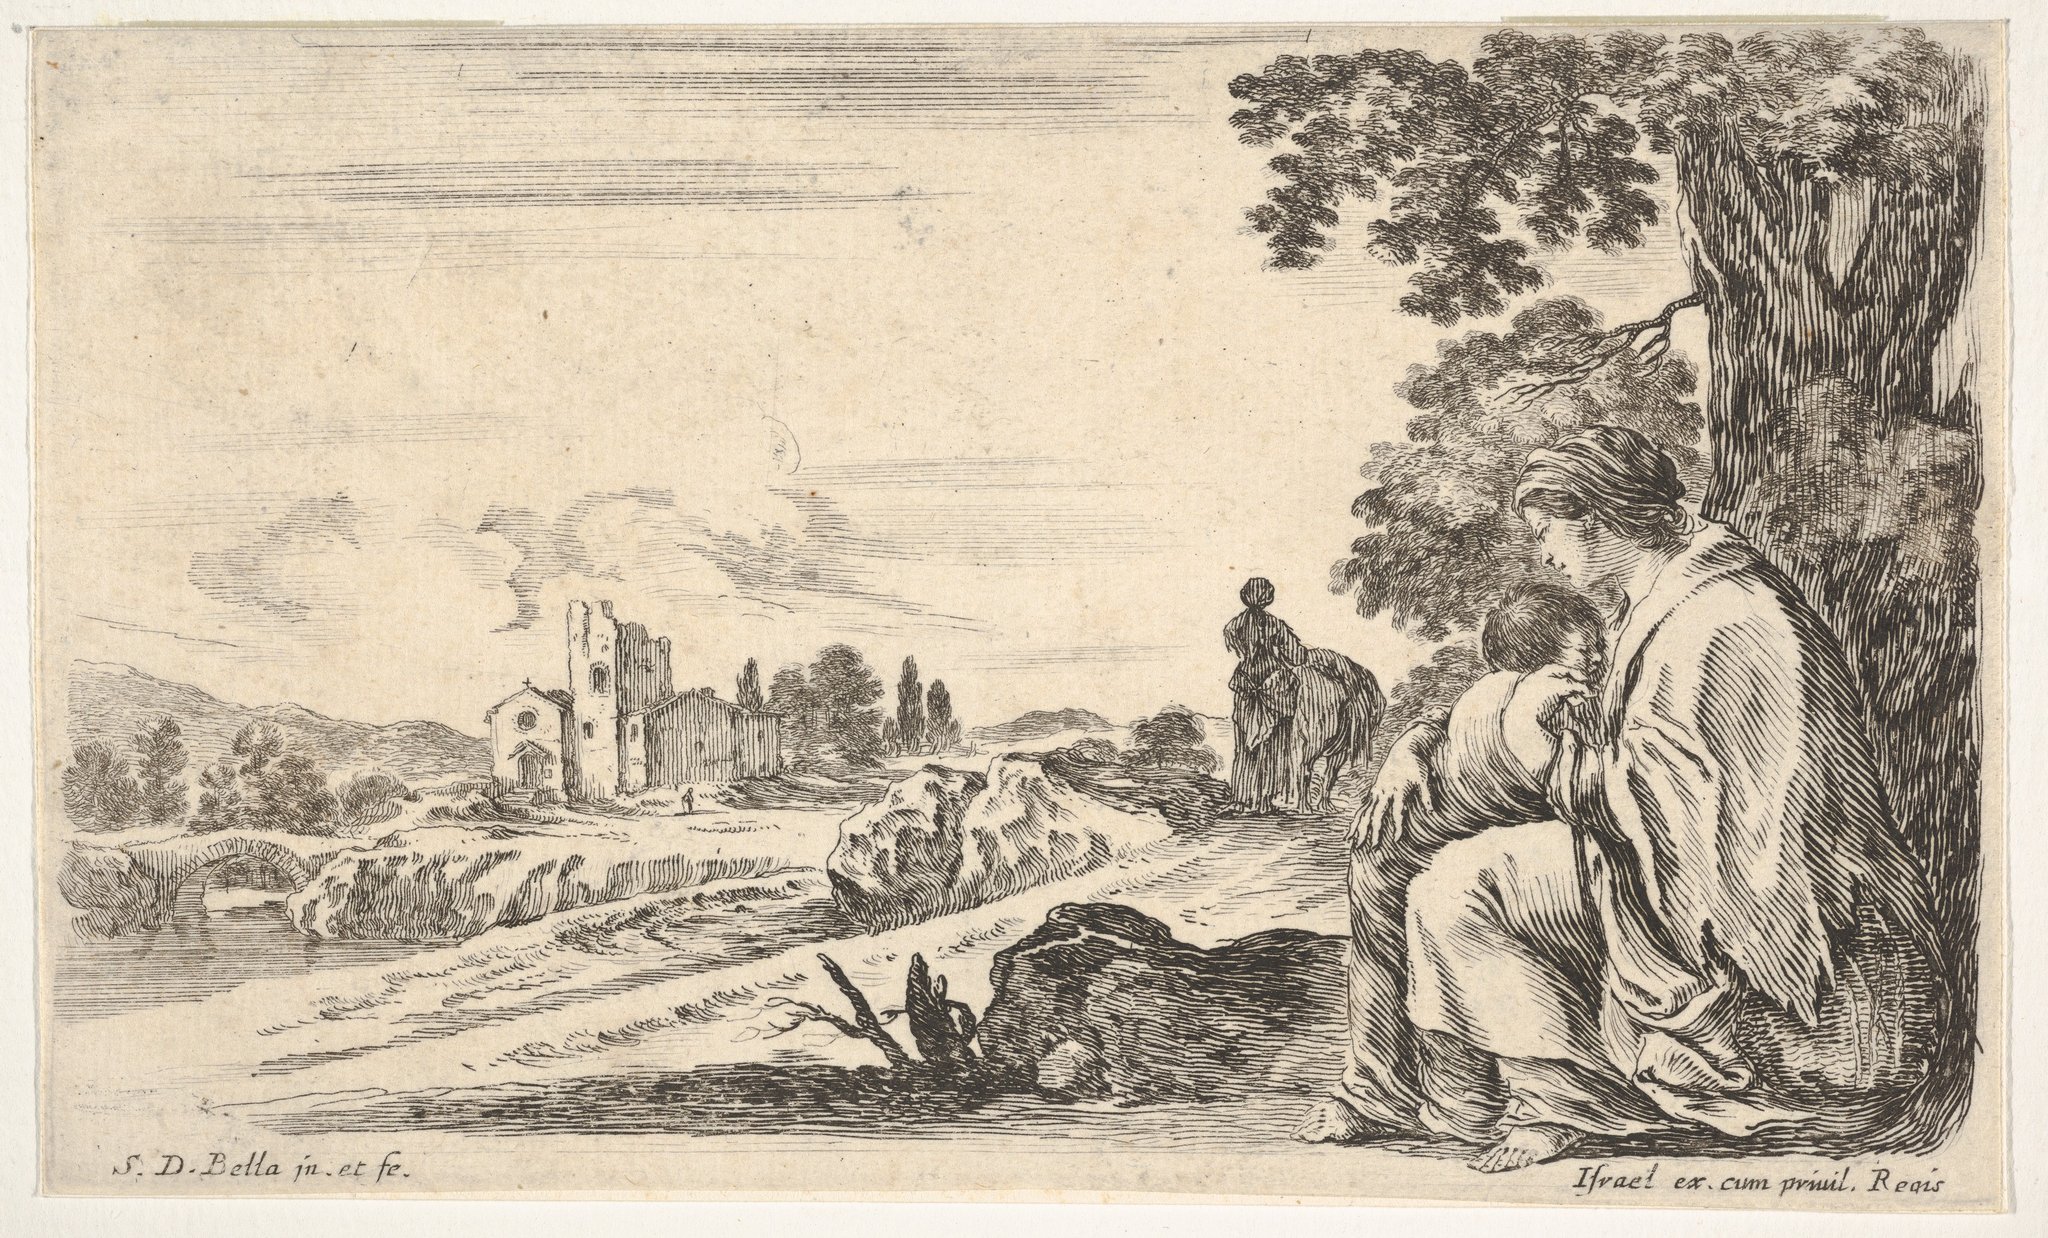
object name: print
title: A peasant woman facing left in profile nurses a baby under a tree at right, a woman, seen from behind, walking next to a donkey in the middle ground, a church and bridge to left in background, from "Various figures and lands" (Diverse figure e paesi)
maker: stefano della bella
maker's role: artist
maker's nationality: italian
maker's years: 1610-1664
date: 1649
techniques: etching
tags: churches,infants,profiles,women,trees